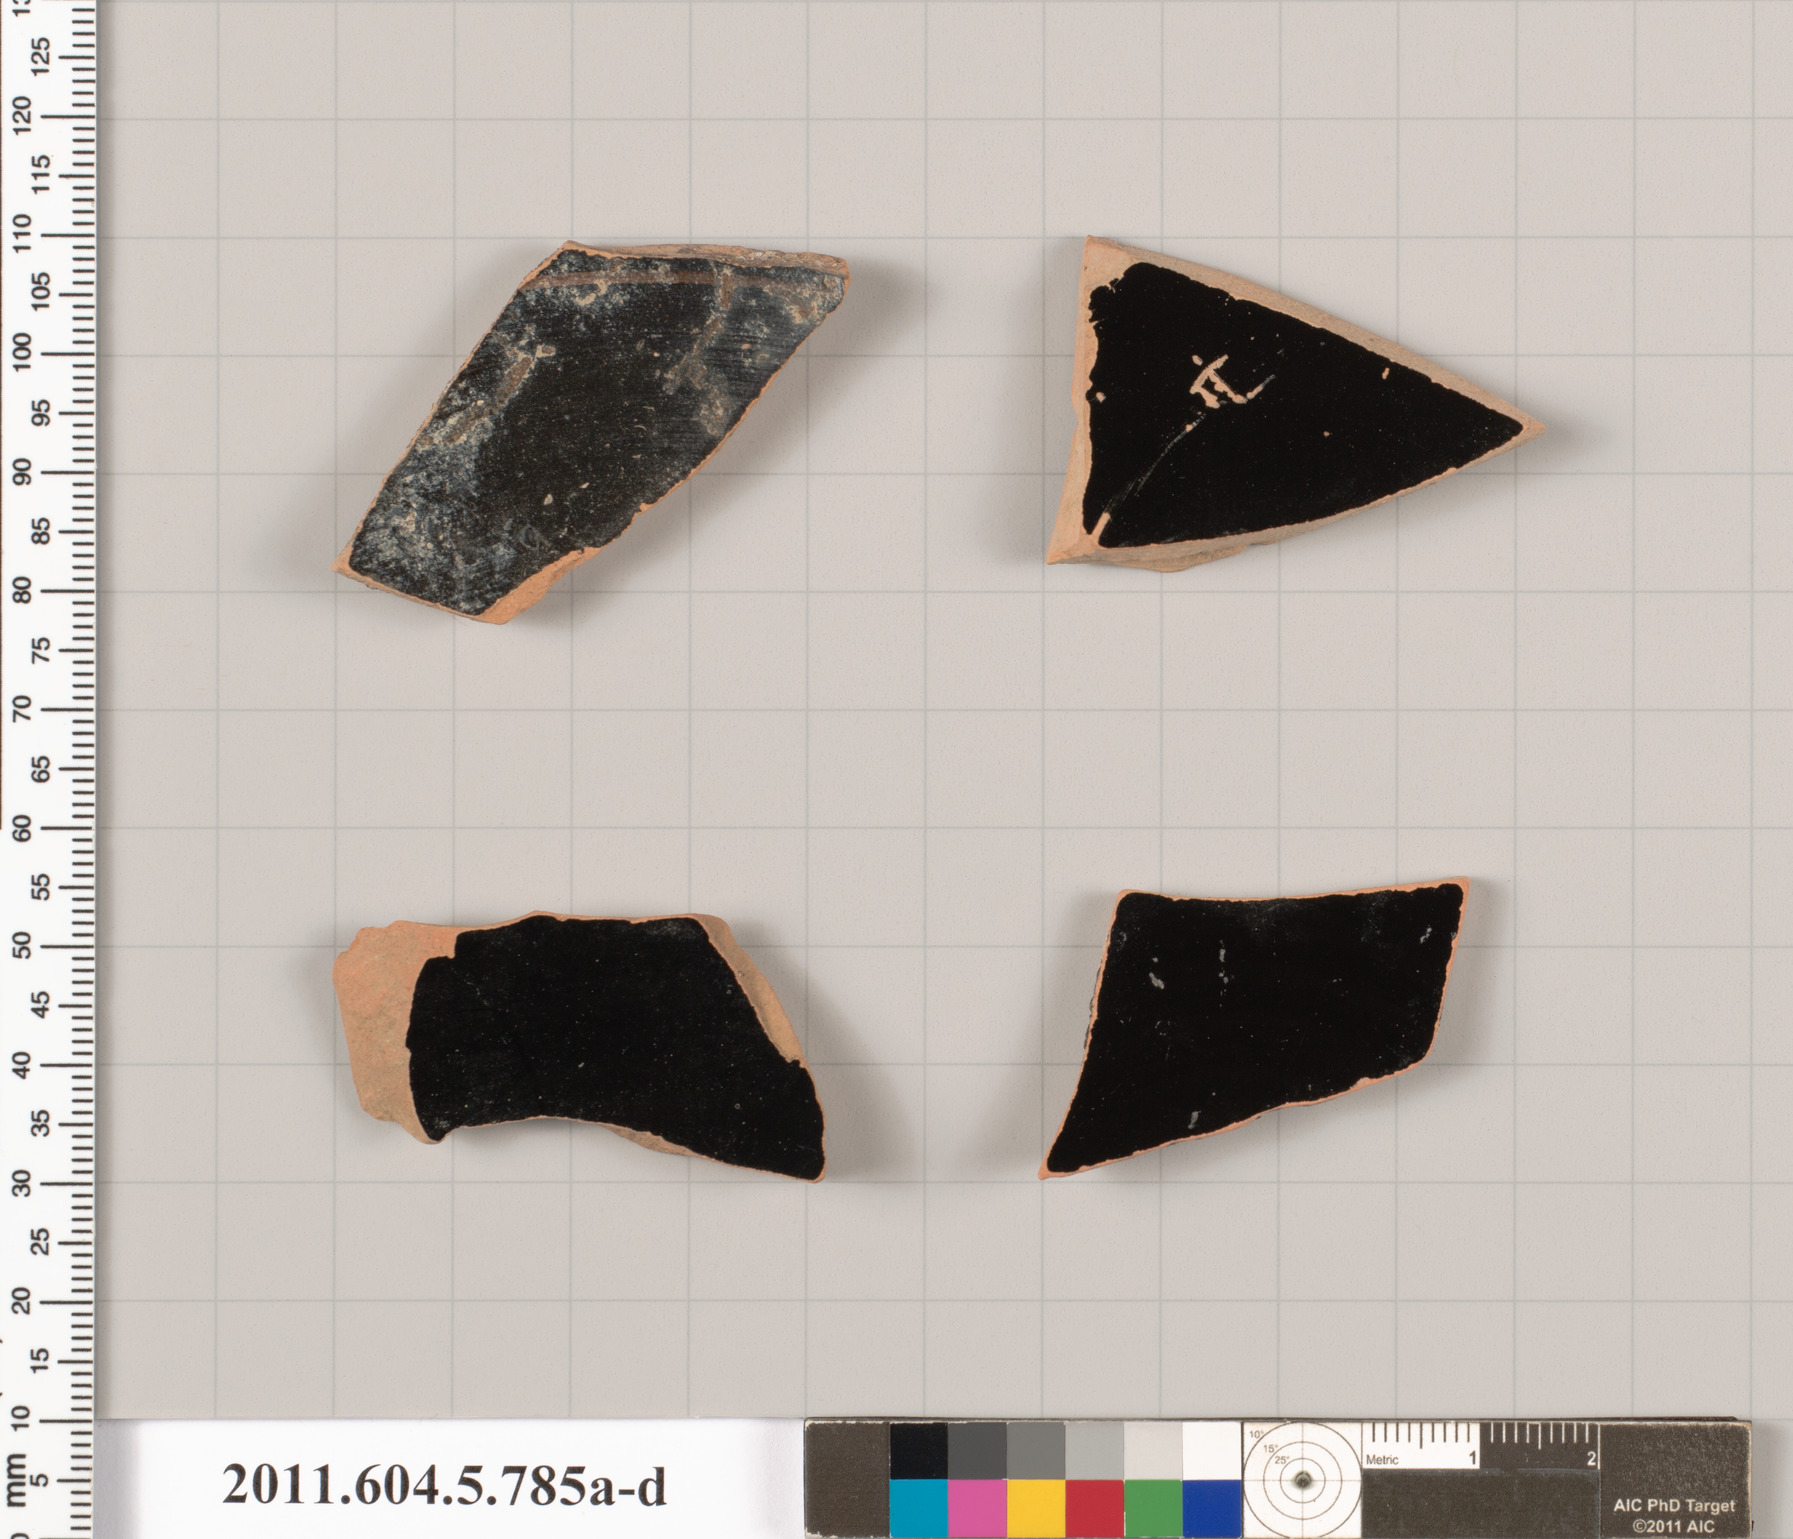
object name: kylix fragment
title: Terracotta fragments of kylikes (drinking cups)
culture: greek, attic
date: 600-401 BCE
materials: terracotta